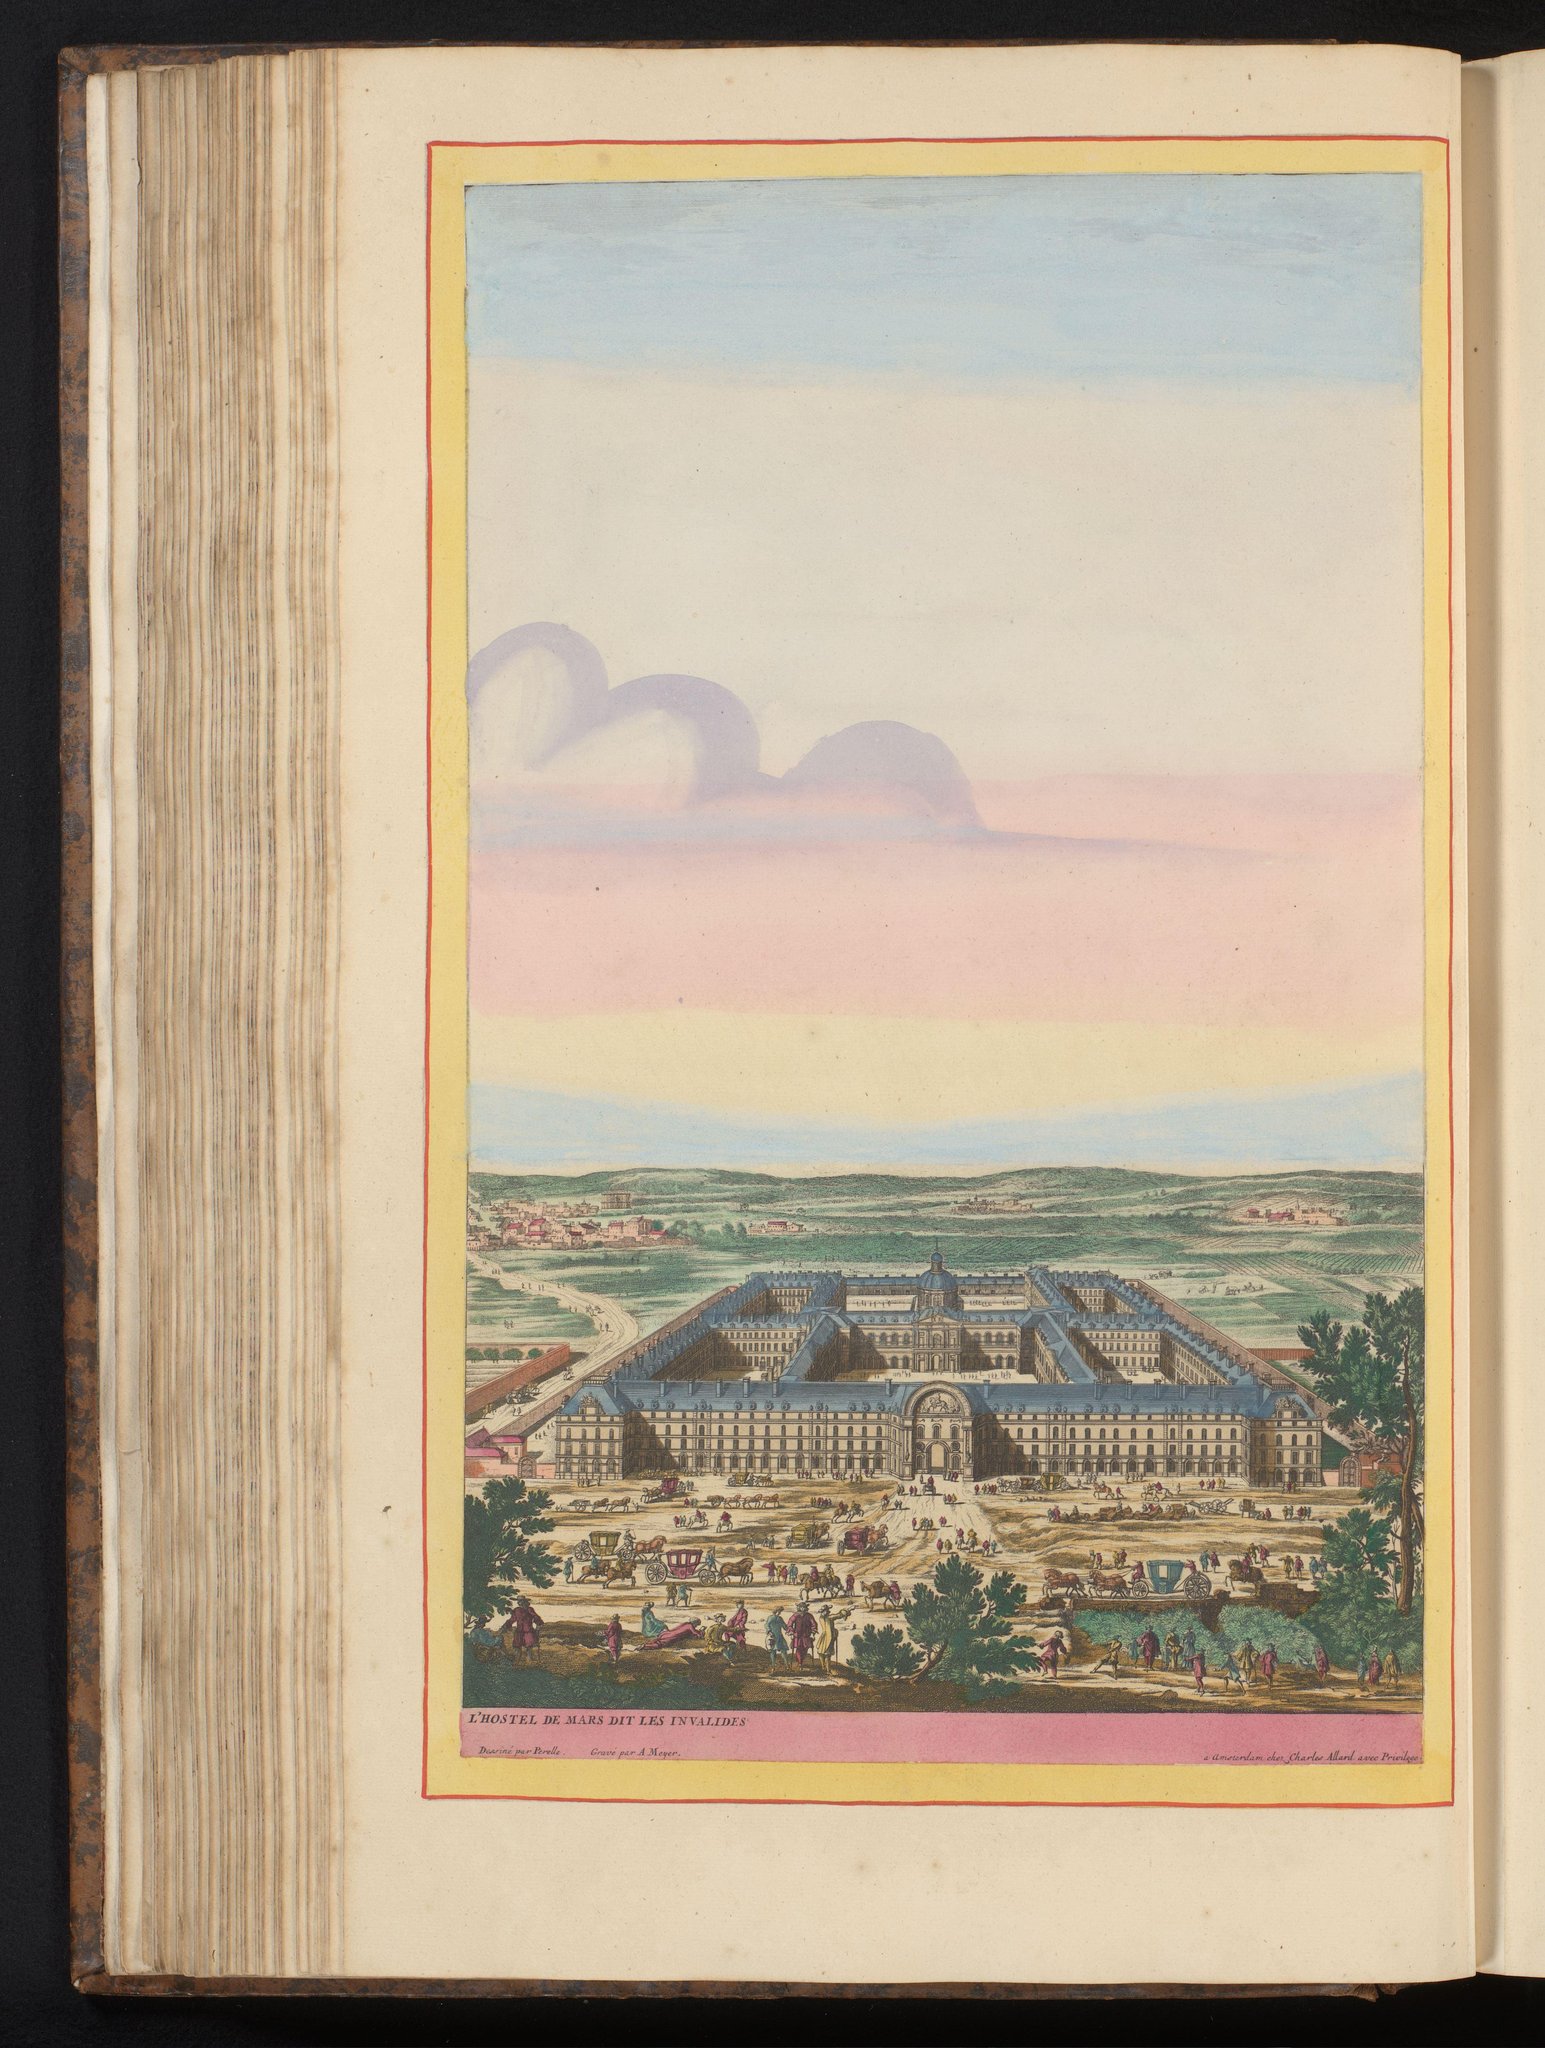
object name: album leaf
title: Gezicht op het Hôtel des Invalides te Parijs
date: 1685-1695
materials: paper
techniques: etching, hand coloring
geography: the hague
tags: old-soldiers-home, 'hôtel des invalides'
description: Gezicht op het Hôtel des Invalides, onderkomen voor oud-soldaten, te Parijs. Prent maakt deel uit van een album.